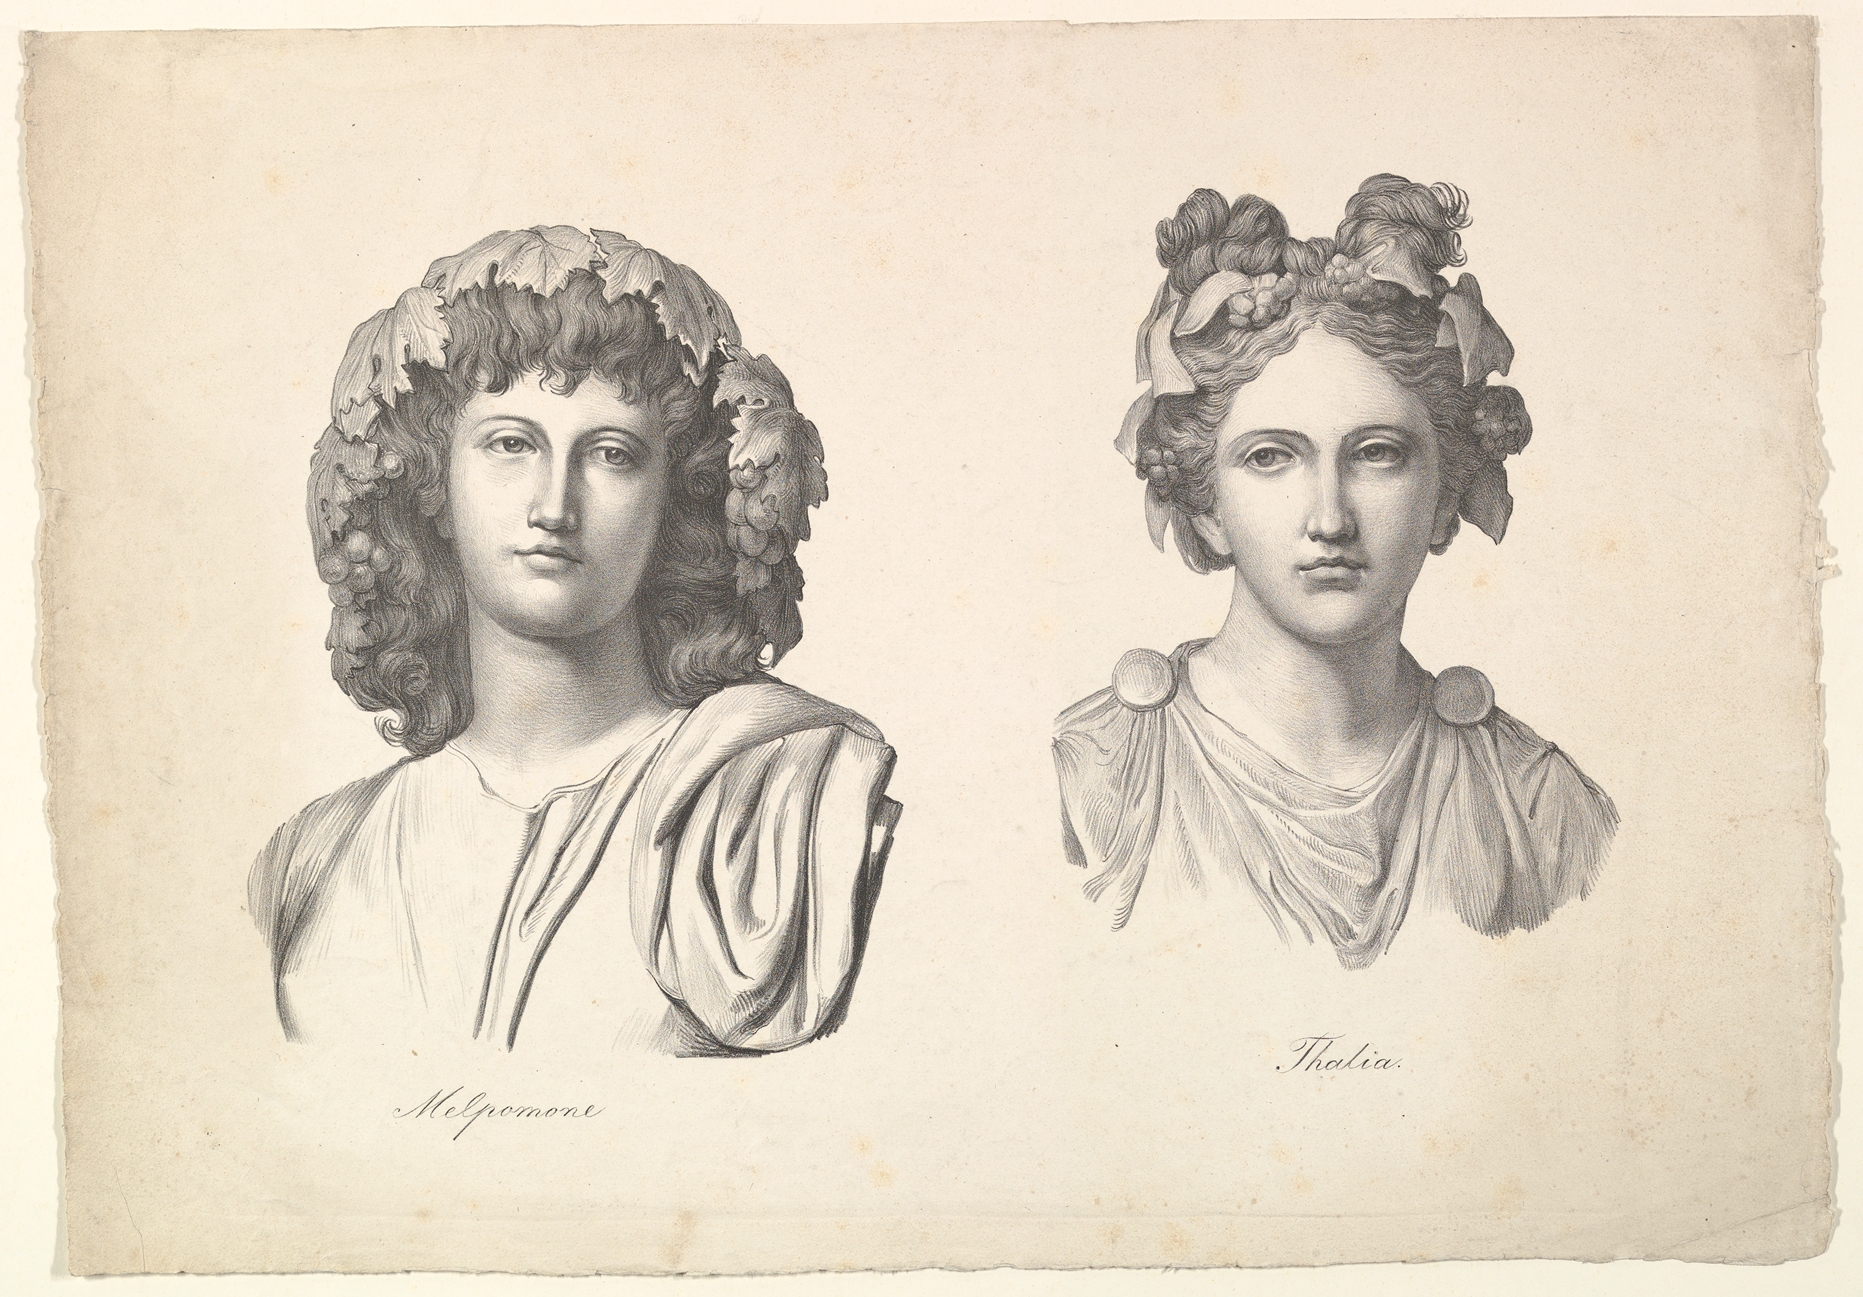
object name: print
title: Melpomene and Thalia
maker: johann gottfried schadow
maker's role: artist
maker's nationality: german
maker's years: 1764-1850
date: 1823-1826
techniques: lithograph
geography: germany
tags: portraits,women